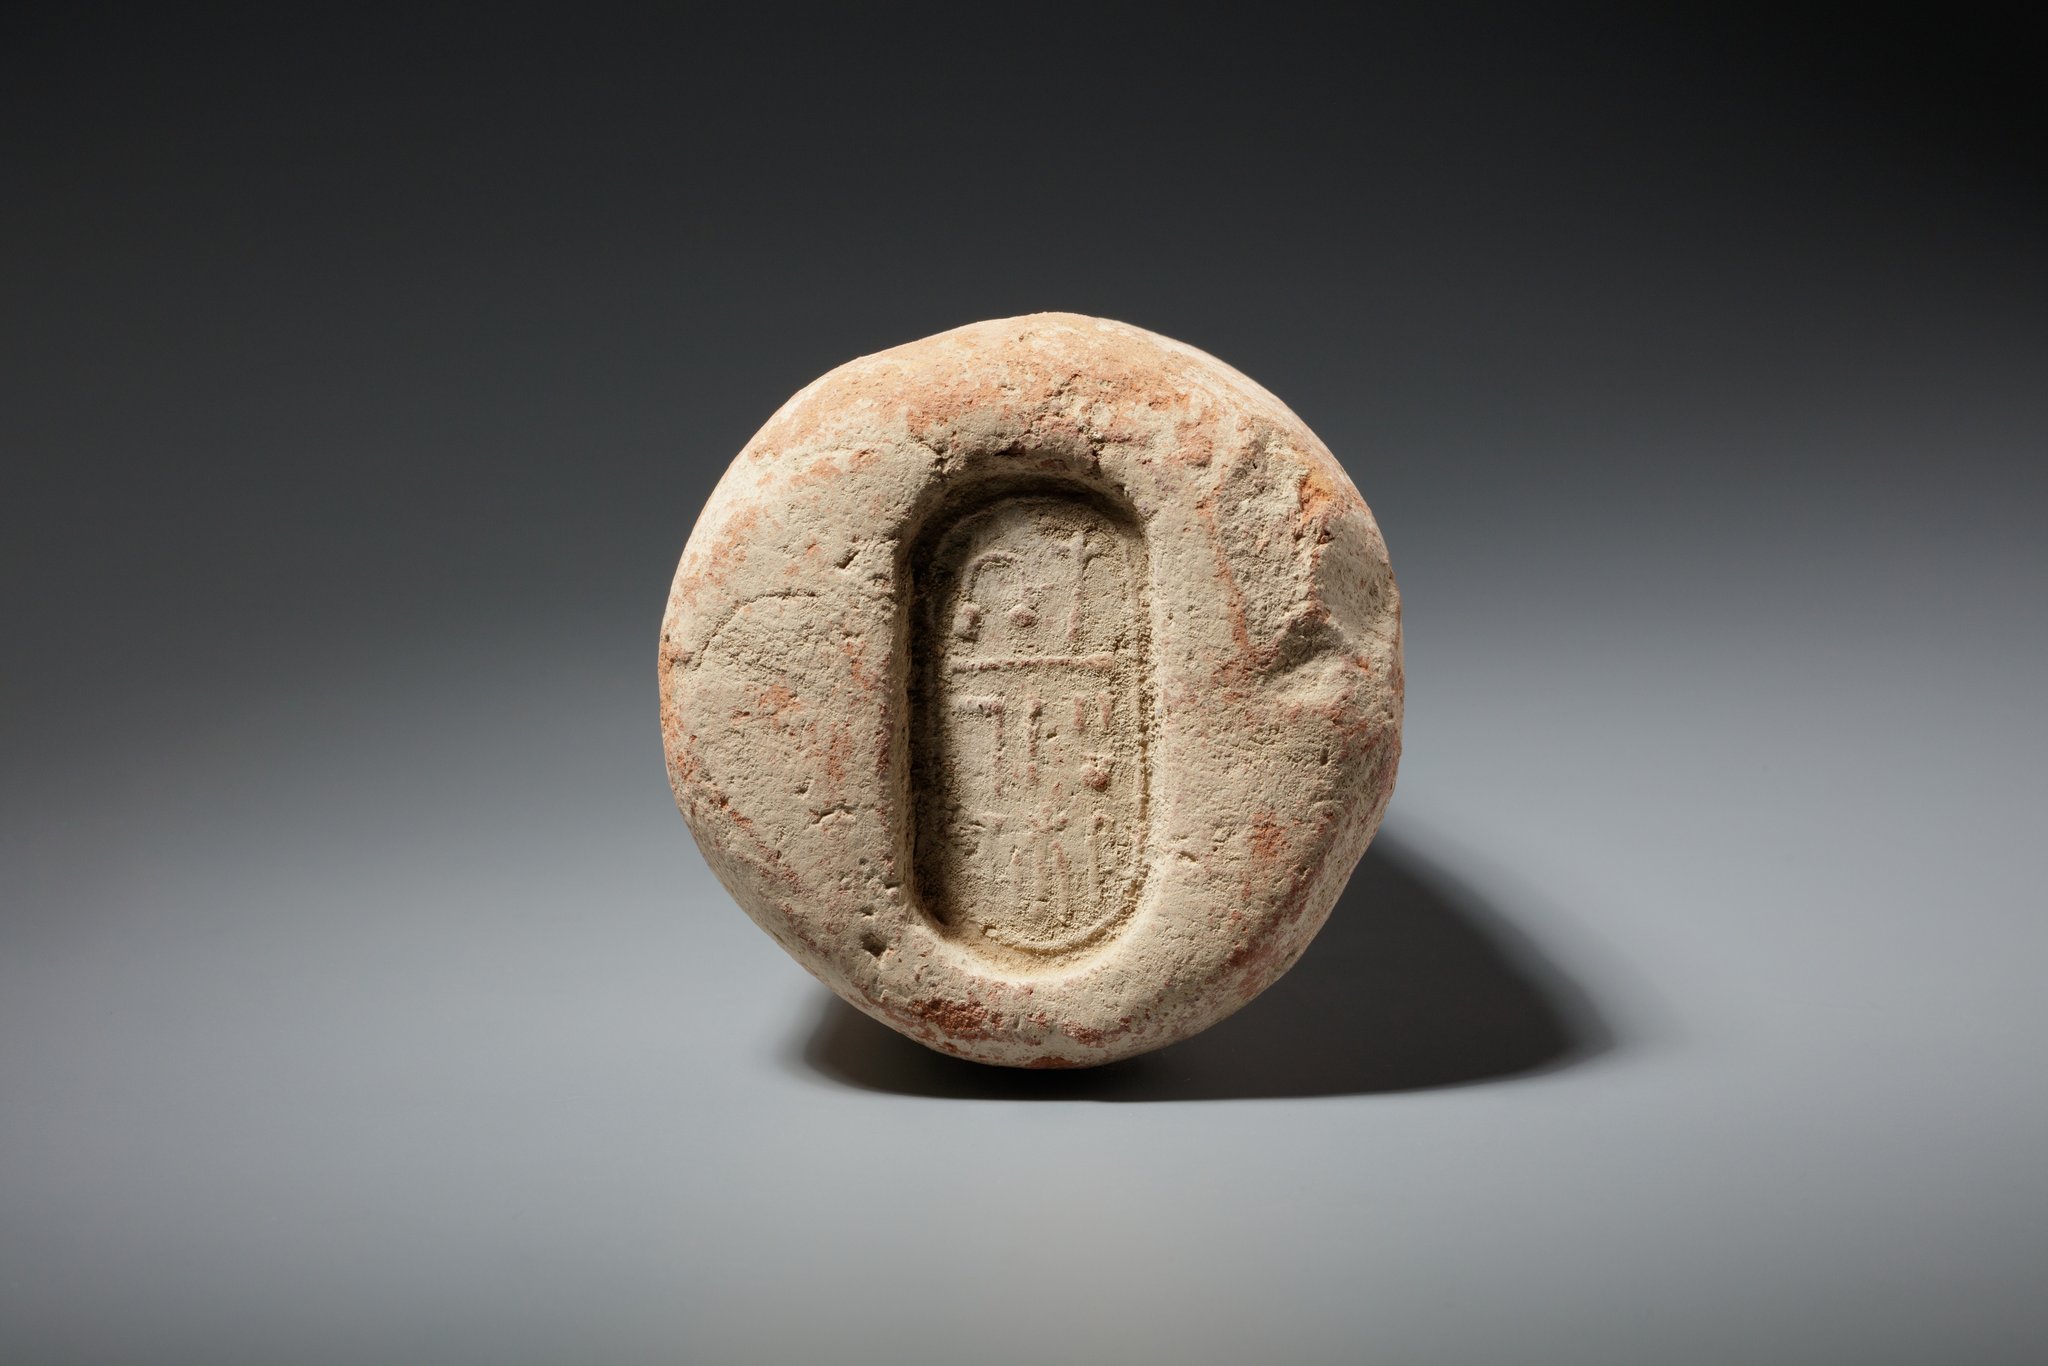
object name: cone, davy 348, wadjmose, scribe, second prophet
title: Funerary Cone of the Scribe Wadjmose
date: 1550-1295 BCE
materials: pottery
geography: egypt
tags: hieroglyphs